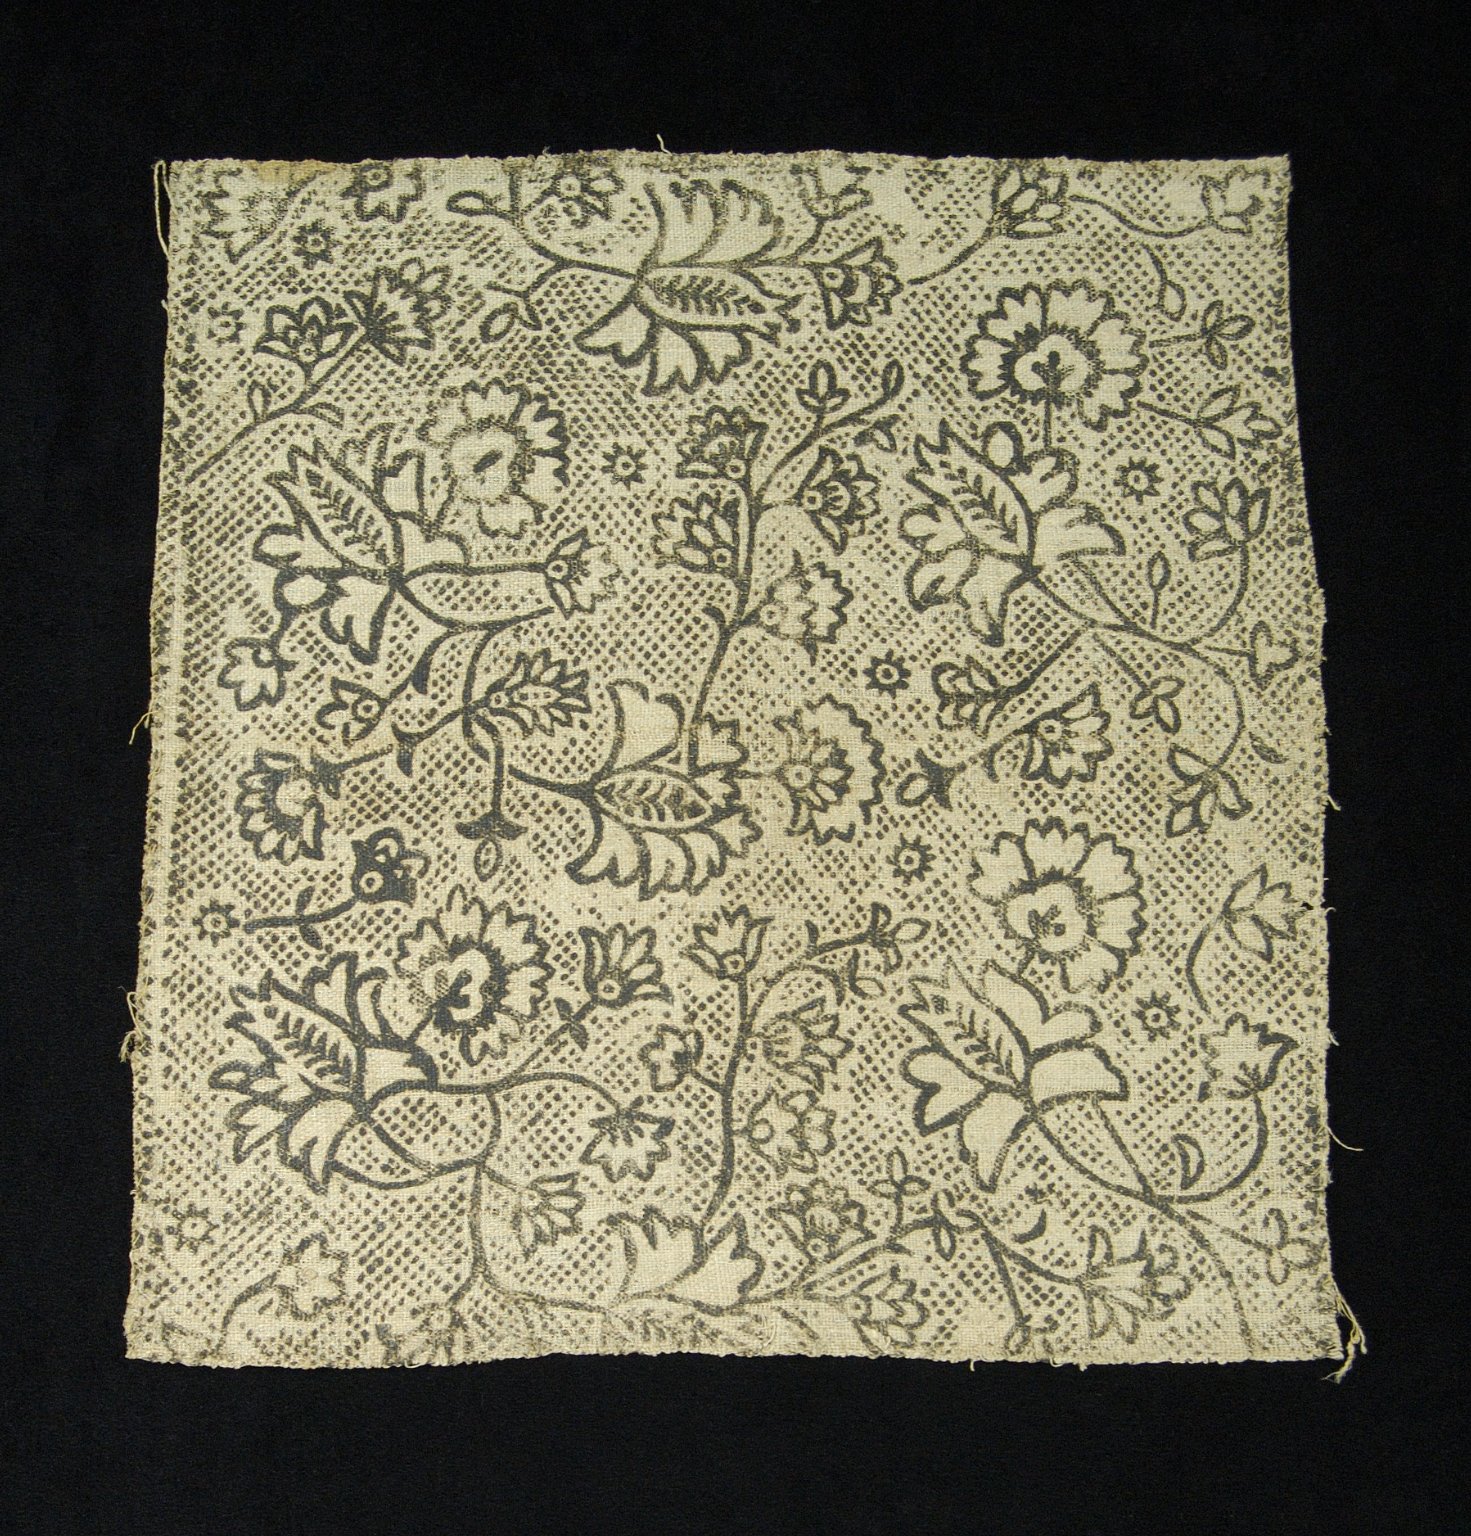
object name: textile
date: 1700-1899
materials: linen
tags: flowers